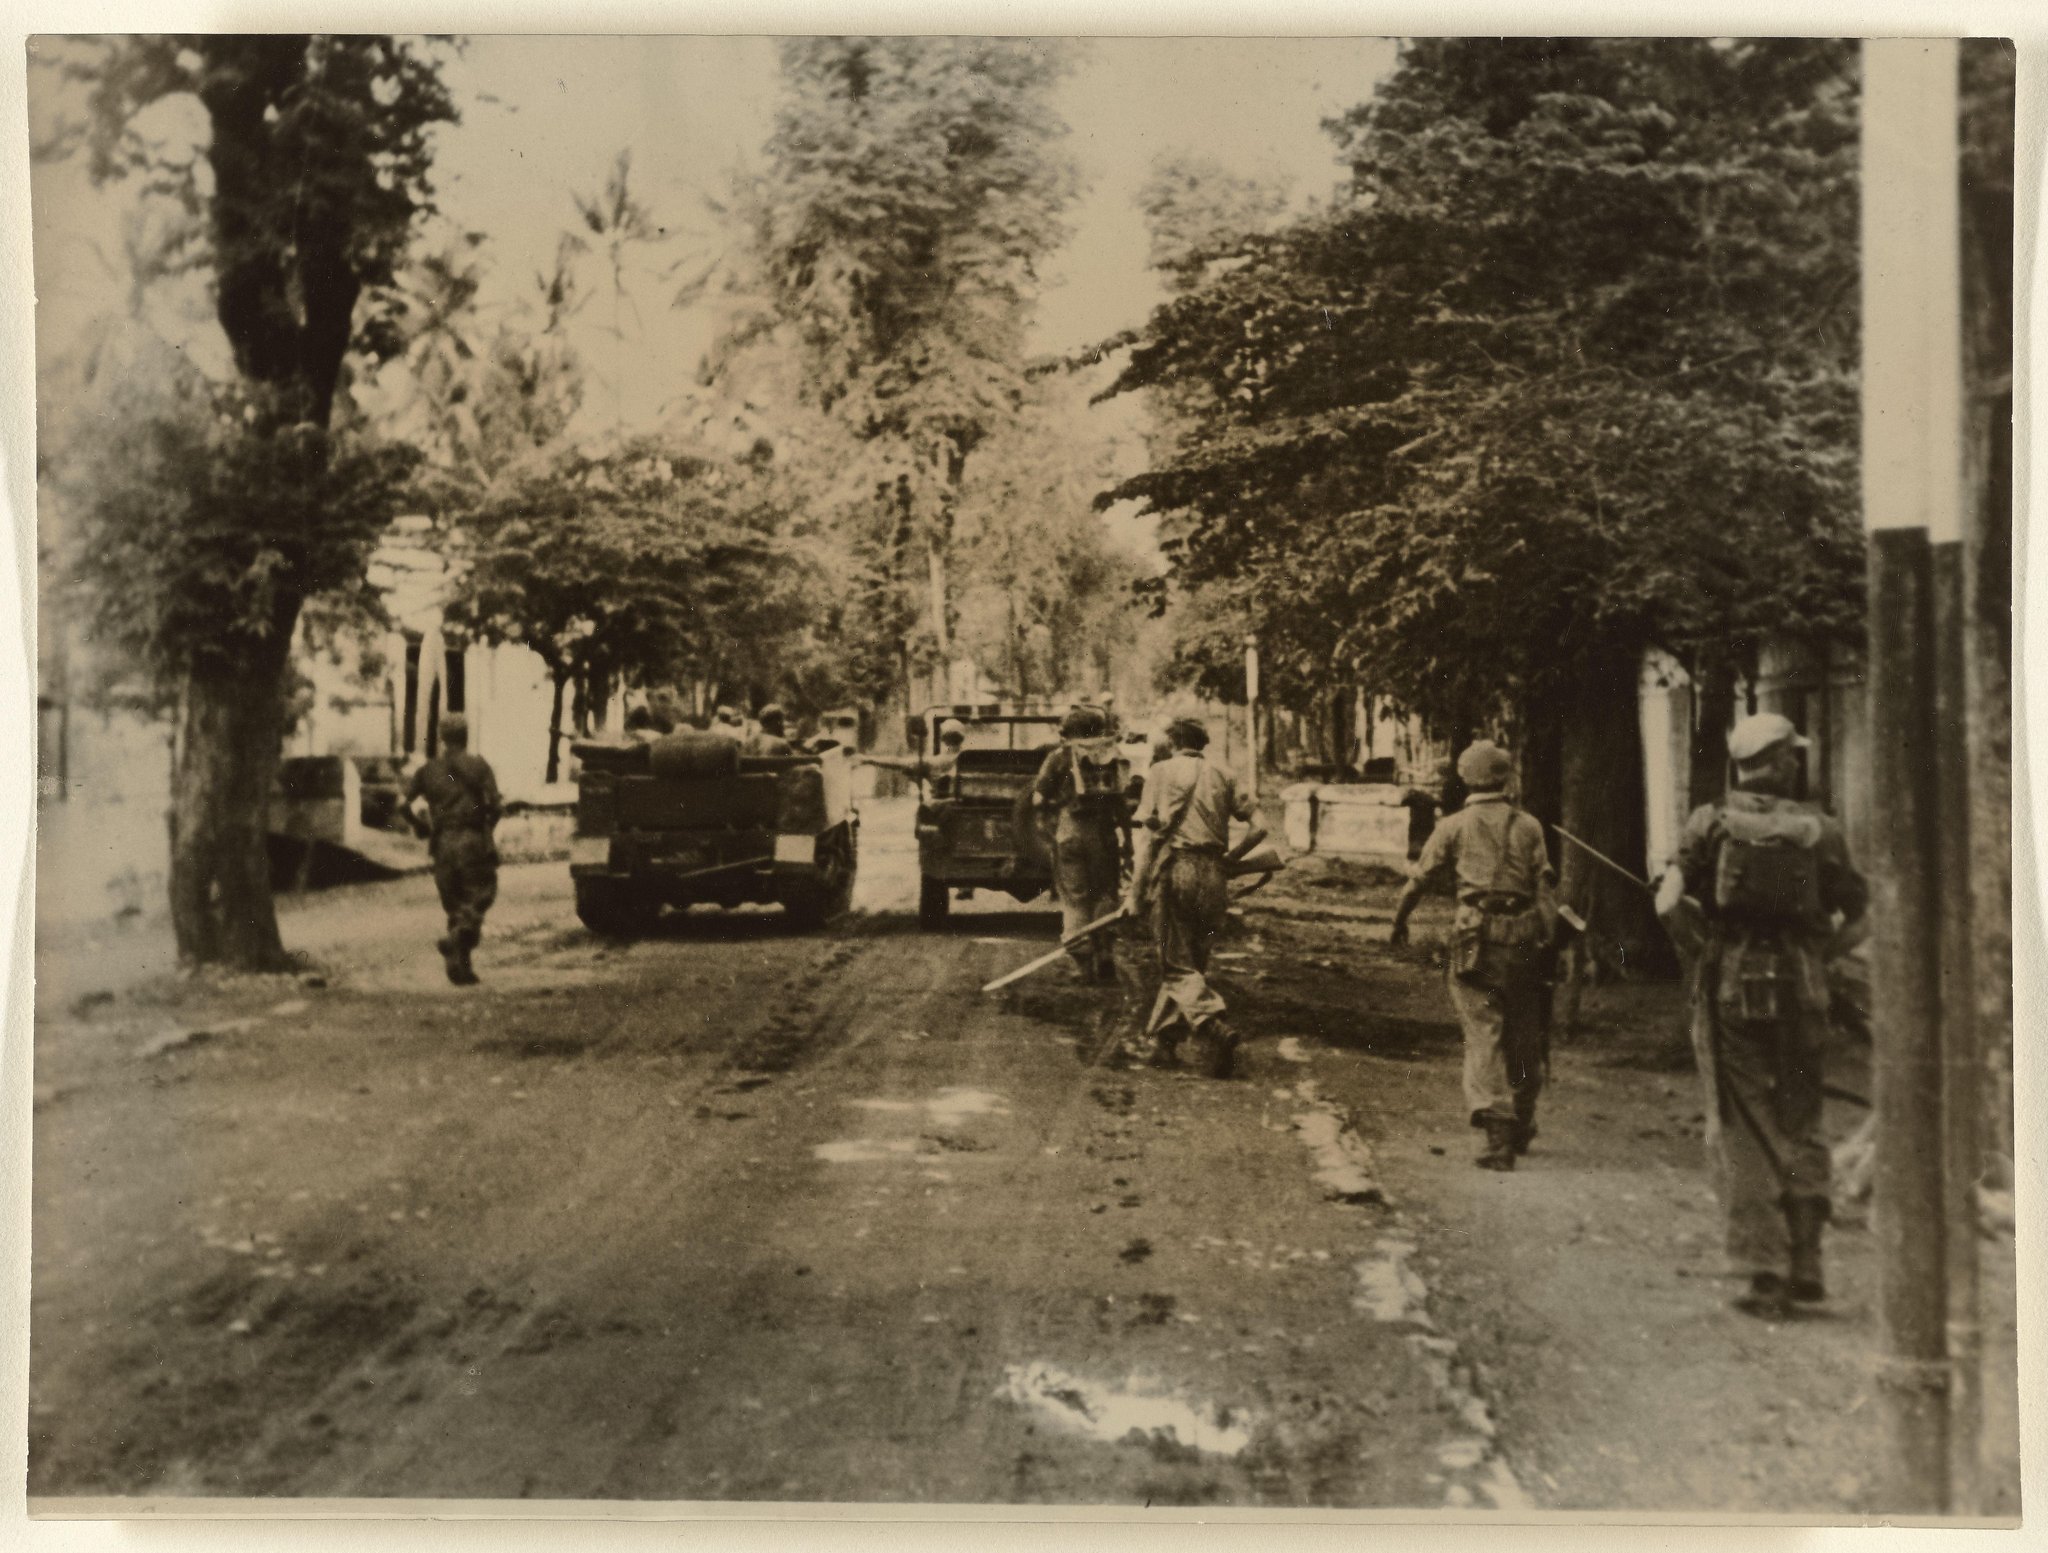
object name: documentary photograph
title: Nederlandse troepen rukken onder dekking van brengun carriers op in Solo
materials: photographic support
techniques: photography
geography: solo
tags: solo, onafhankelijkheid indonesië, tweede militaire actie (1948-1949)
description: Nederlandse troepen rukken onder dekking van brenguns (=machinegeweer) carriers (=ijzeren bak op rupsbanden) op in de buitenwijken van Solo. In een verlaten ongeplaveide straat met aan weerszijden bomen rukken allereerst twee brengun carriers op met daarachter een vijftal Nederlandse militairen te voet.